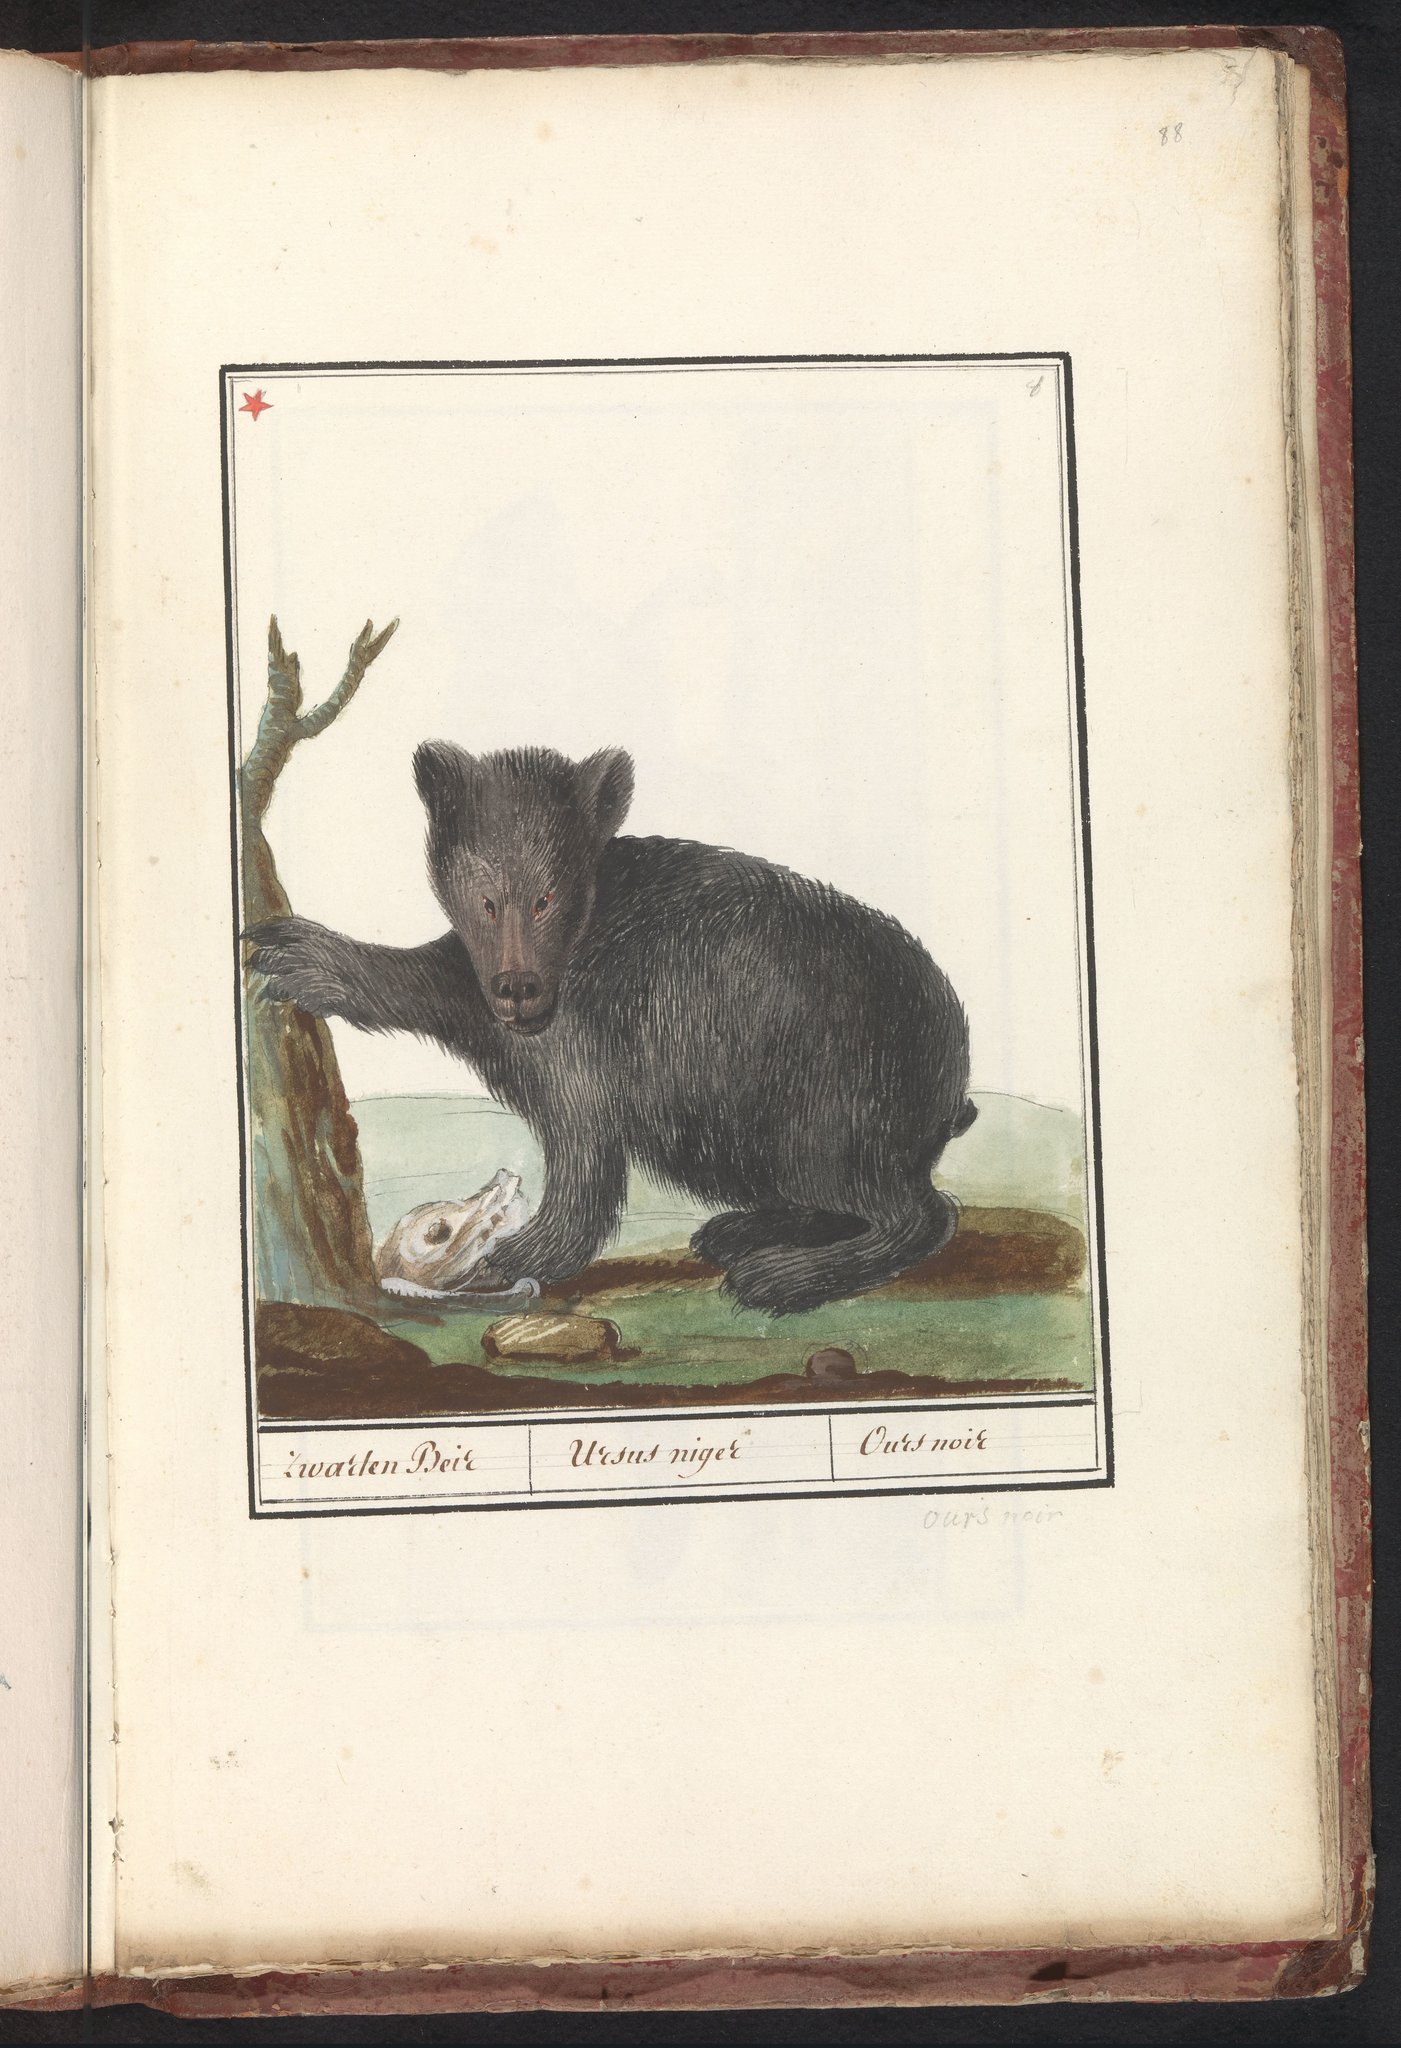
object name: drawing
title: Zwarten Beir / Ursus niger / Ours noir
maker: Anonymous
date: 1790-1814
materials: chalk, paint, paper, watercolor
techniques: brush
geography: southern netherlands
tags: beasts of prey, predatory animals: bear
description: Zwarte beer. Rechtsboven genummerd: 8. Linksboven gemerkt met een rood sterretje. Onderdeel van het eerste album met tekeningen van viervoeters. Eerste van twaalf albums met tekeningen van dieren, vogels en planten bekend rond 1600, gemaakt in opdracht van keizer Rudolf II. Met toelichting in Nederlands, Latijn en Frans.